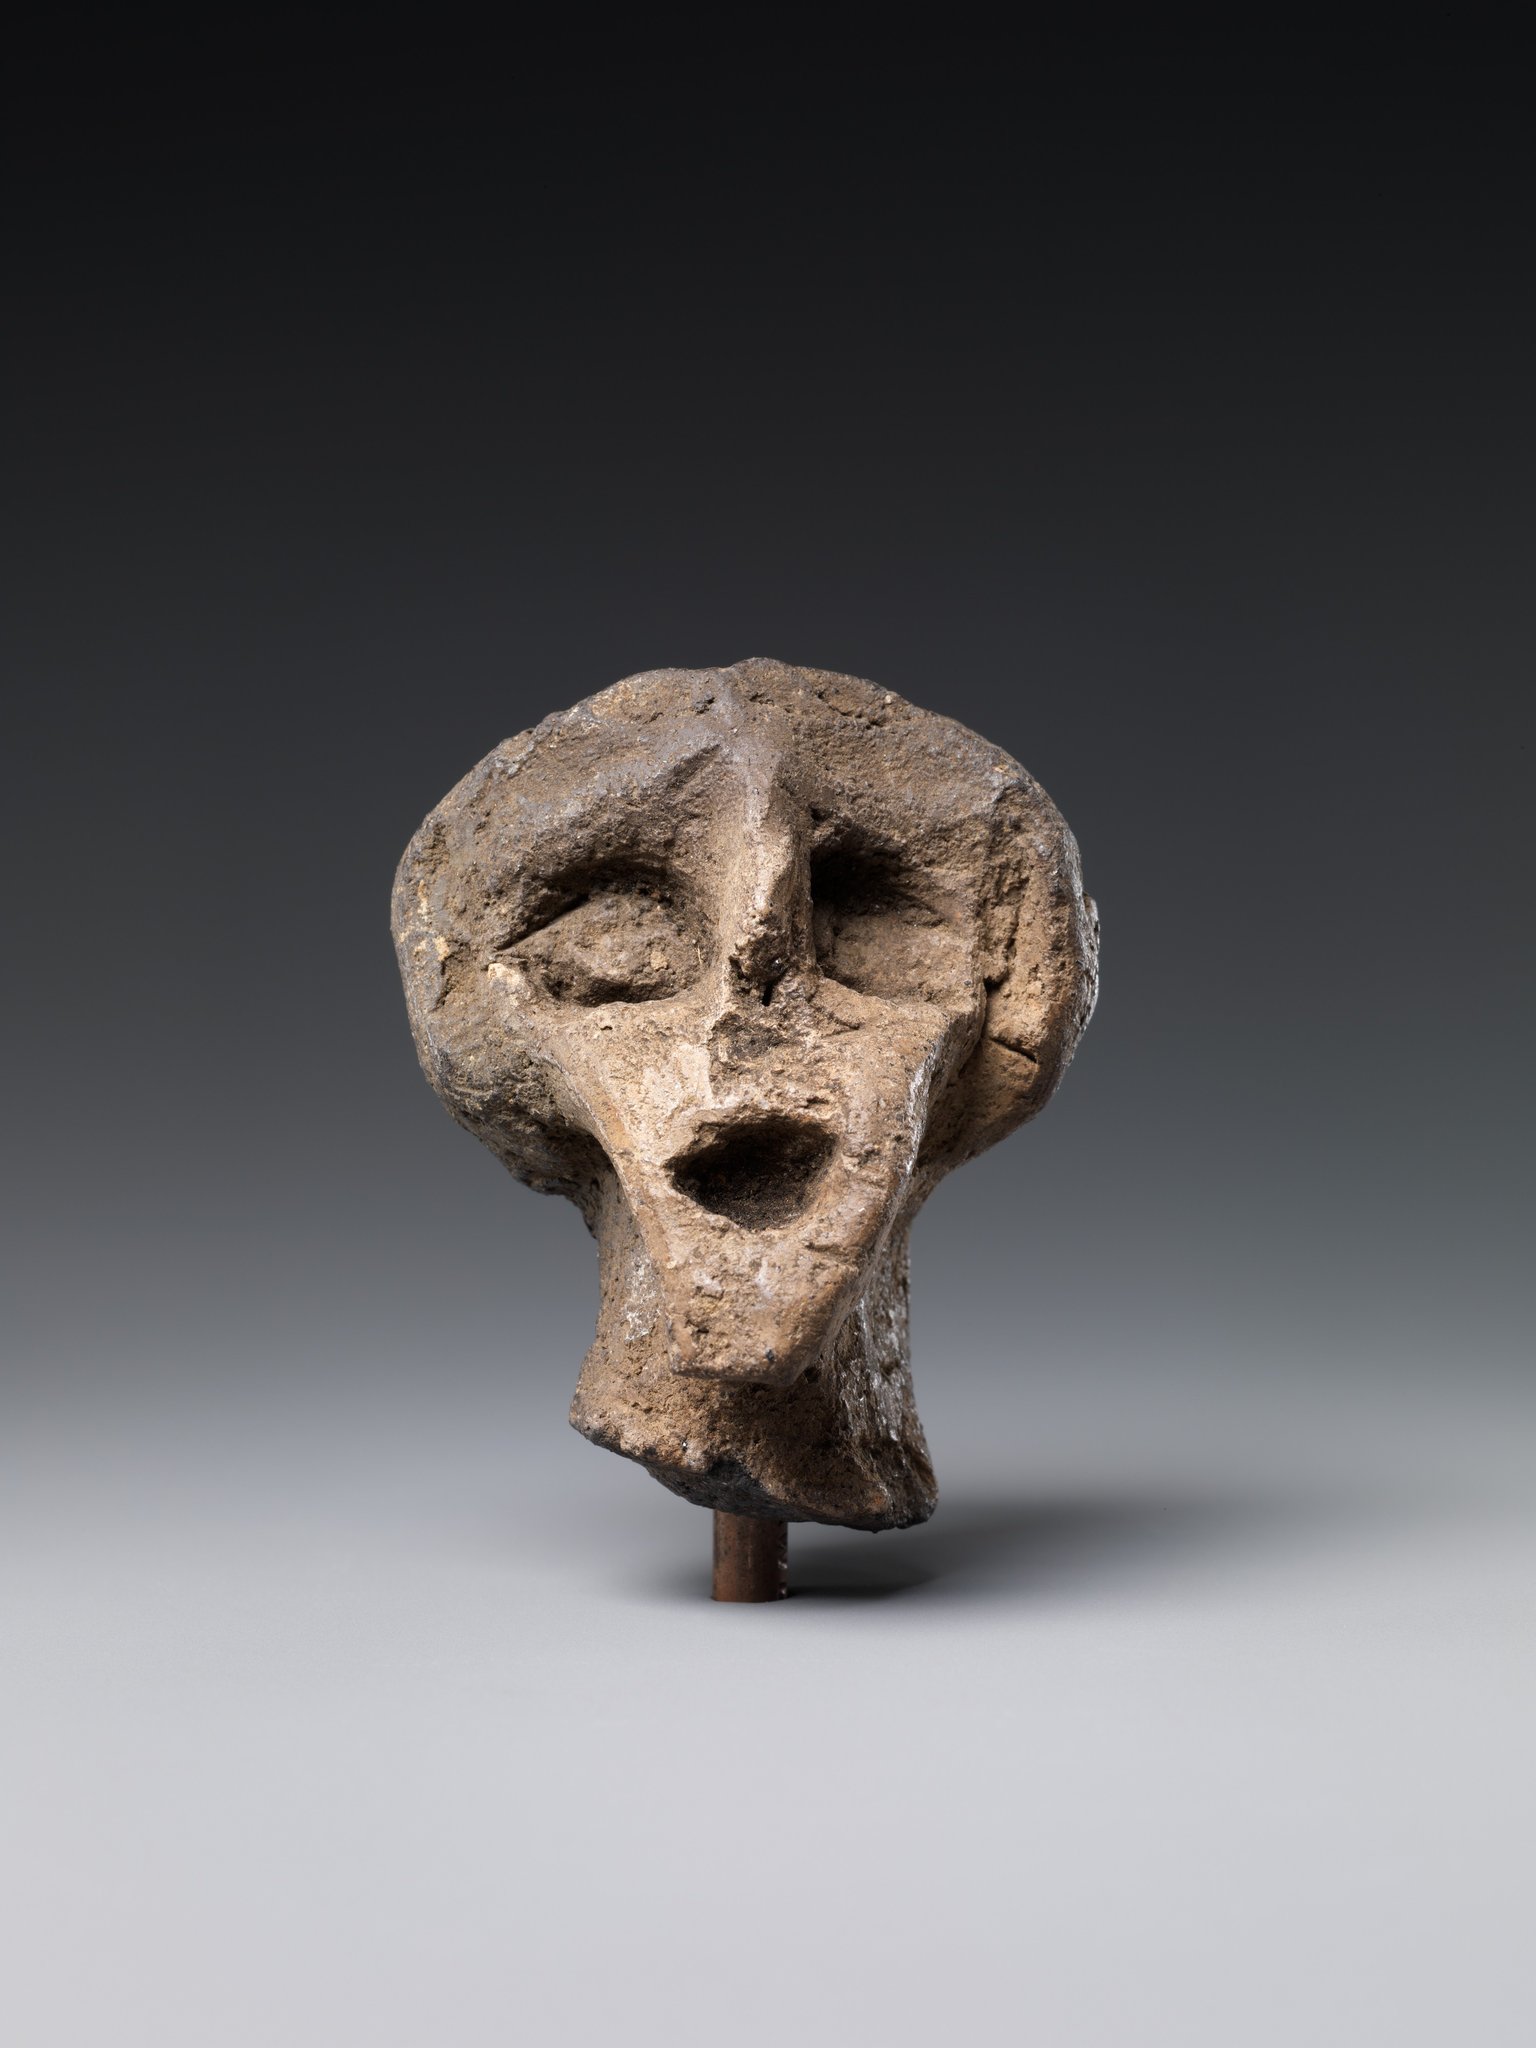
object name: head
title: Head of a Clay Figure (Dogū)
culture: japanese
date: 1500-1000 BCE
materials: earthenware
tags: heads